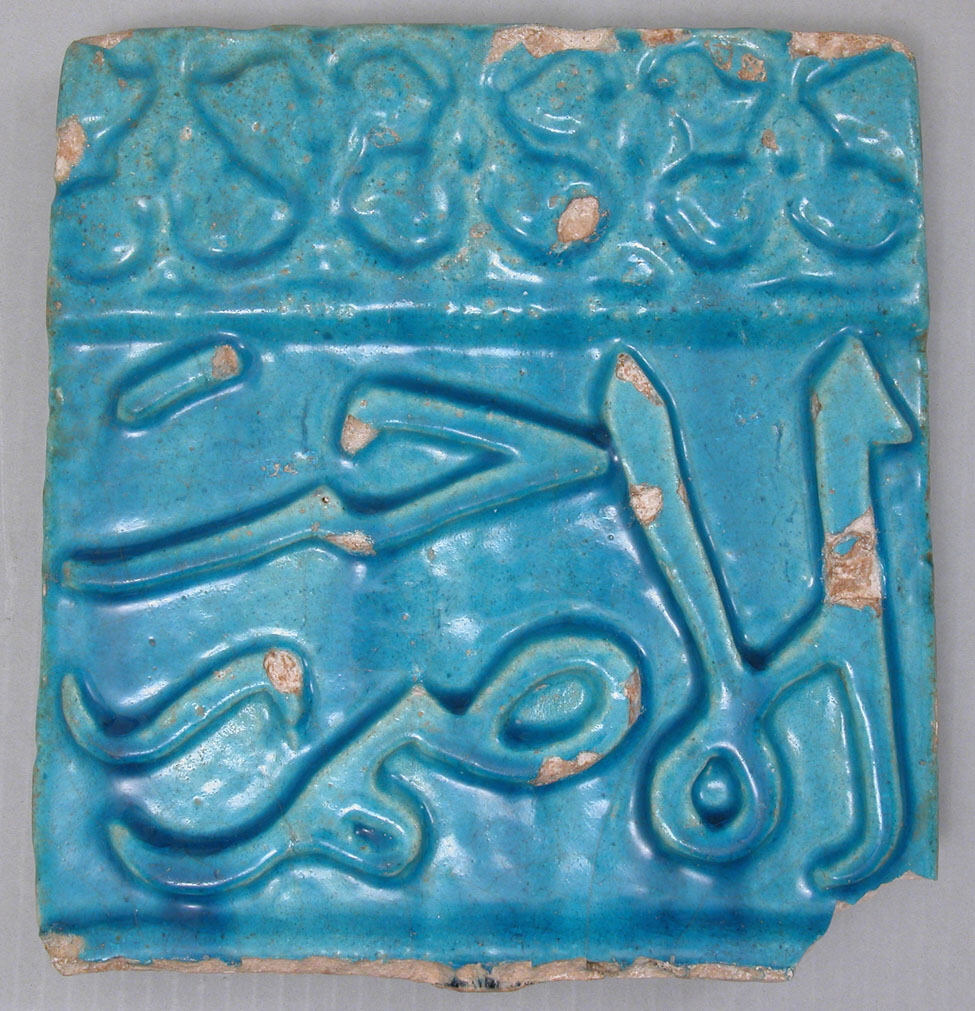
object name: tile from a frieze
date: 1101-1200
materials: stonepaste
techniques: glazing, molding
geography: iran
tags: arabic